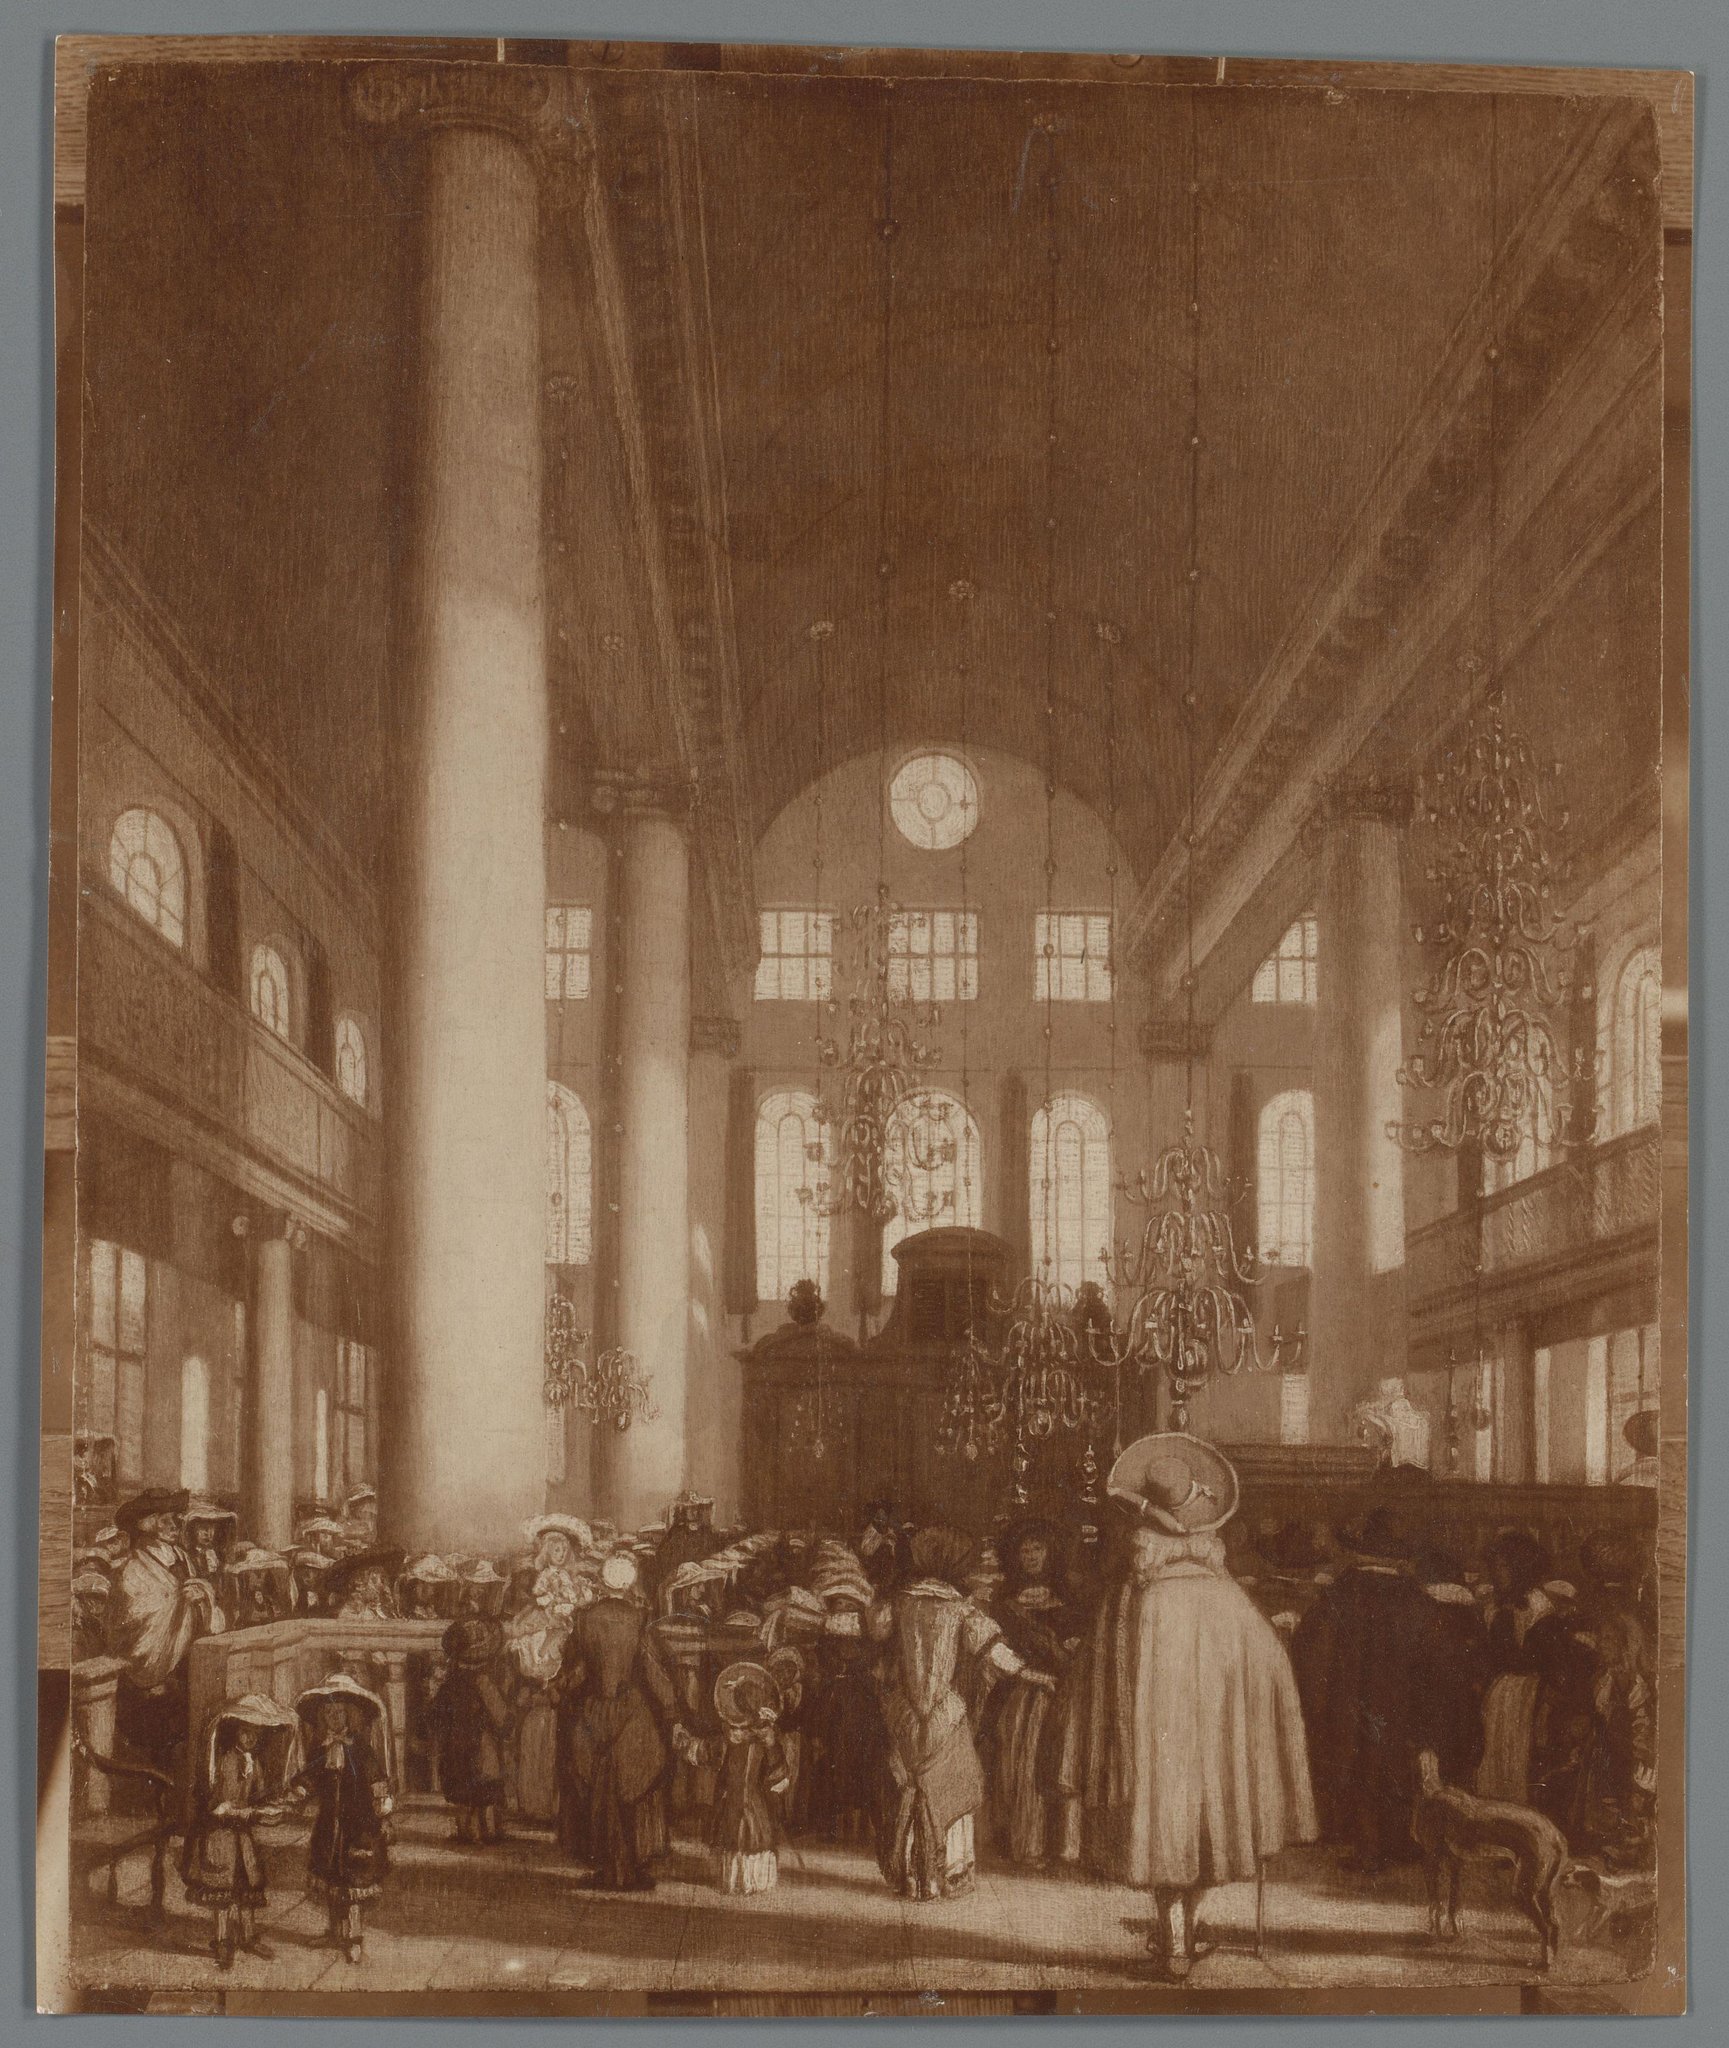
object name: reproduction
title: Fotoreproductie van schilderij van een kerkinterieur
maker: Anonymous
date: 1890-1920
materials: paper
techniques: gelatin silver print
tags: interior of church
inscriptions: number: ‘448’, stamp: ‘Galerie/ van Diemen & Co., G.m.b.H./ Berlin W.8/ Unter den Linden 17.’, inscription: ‘7440-37/ 9 1/2 binnen’, inscription: ‘45 x 53,5 cm’